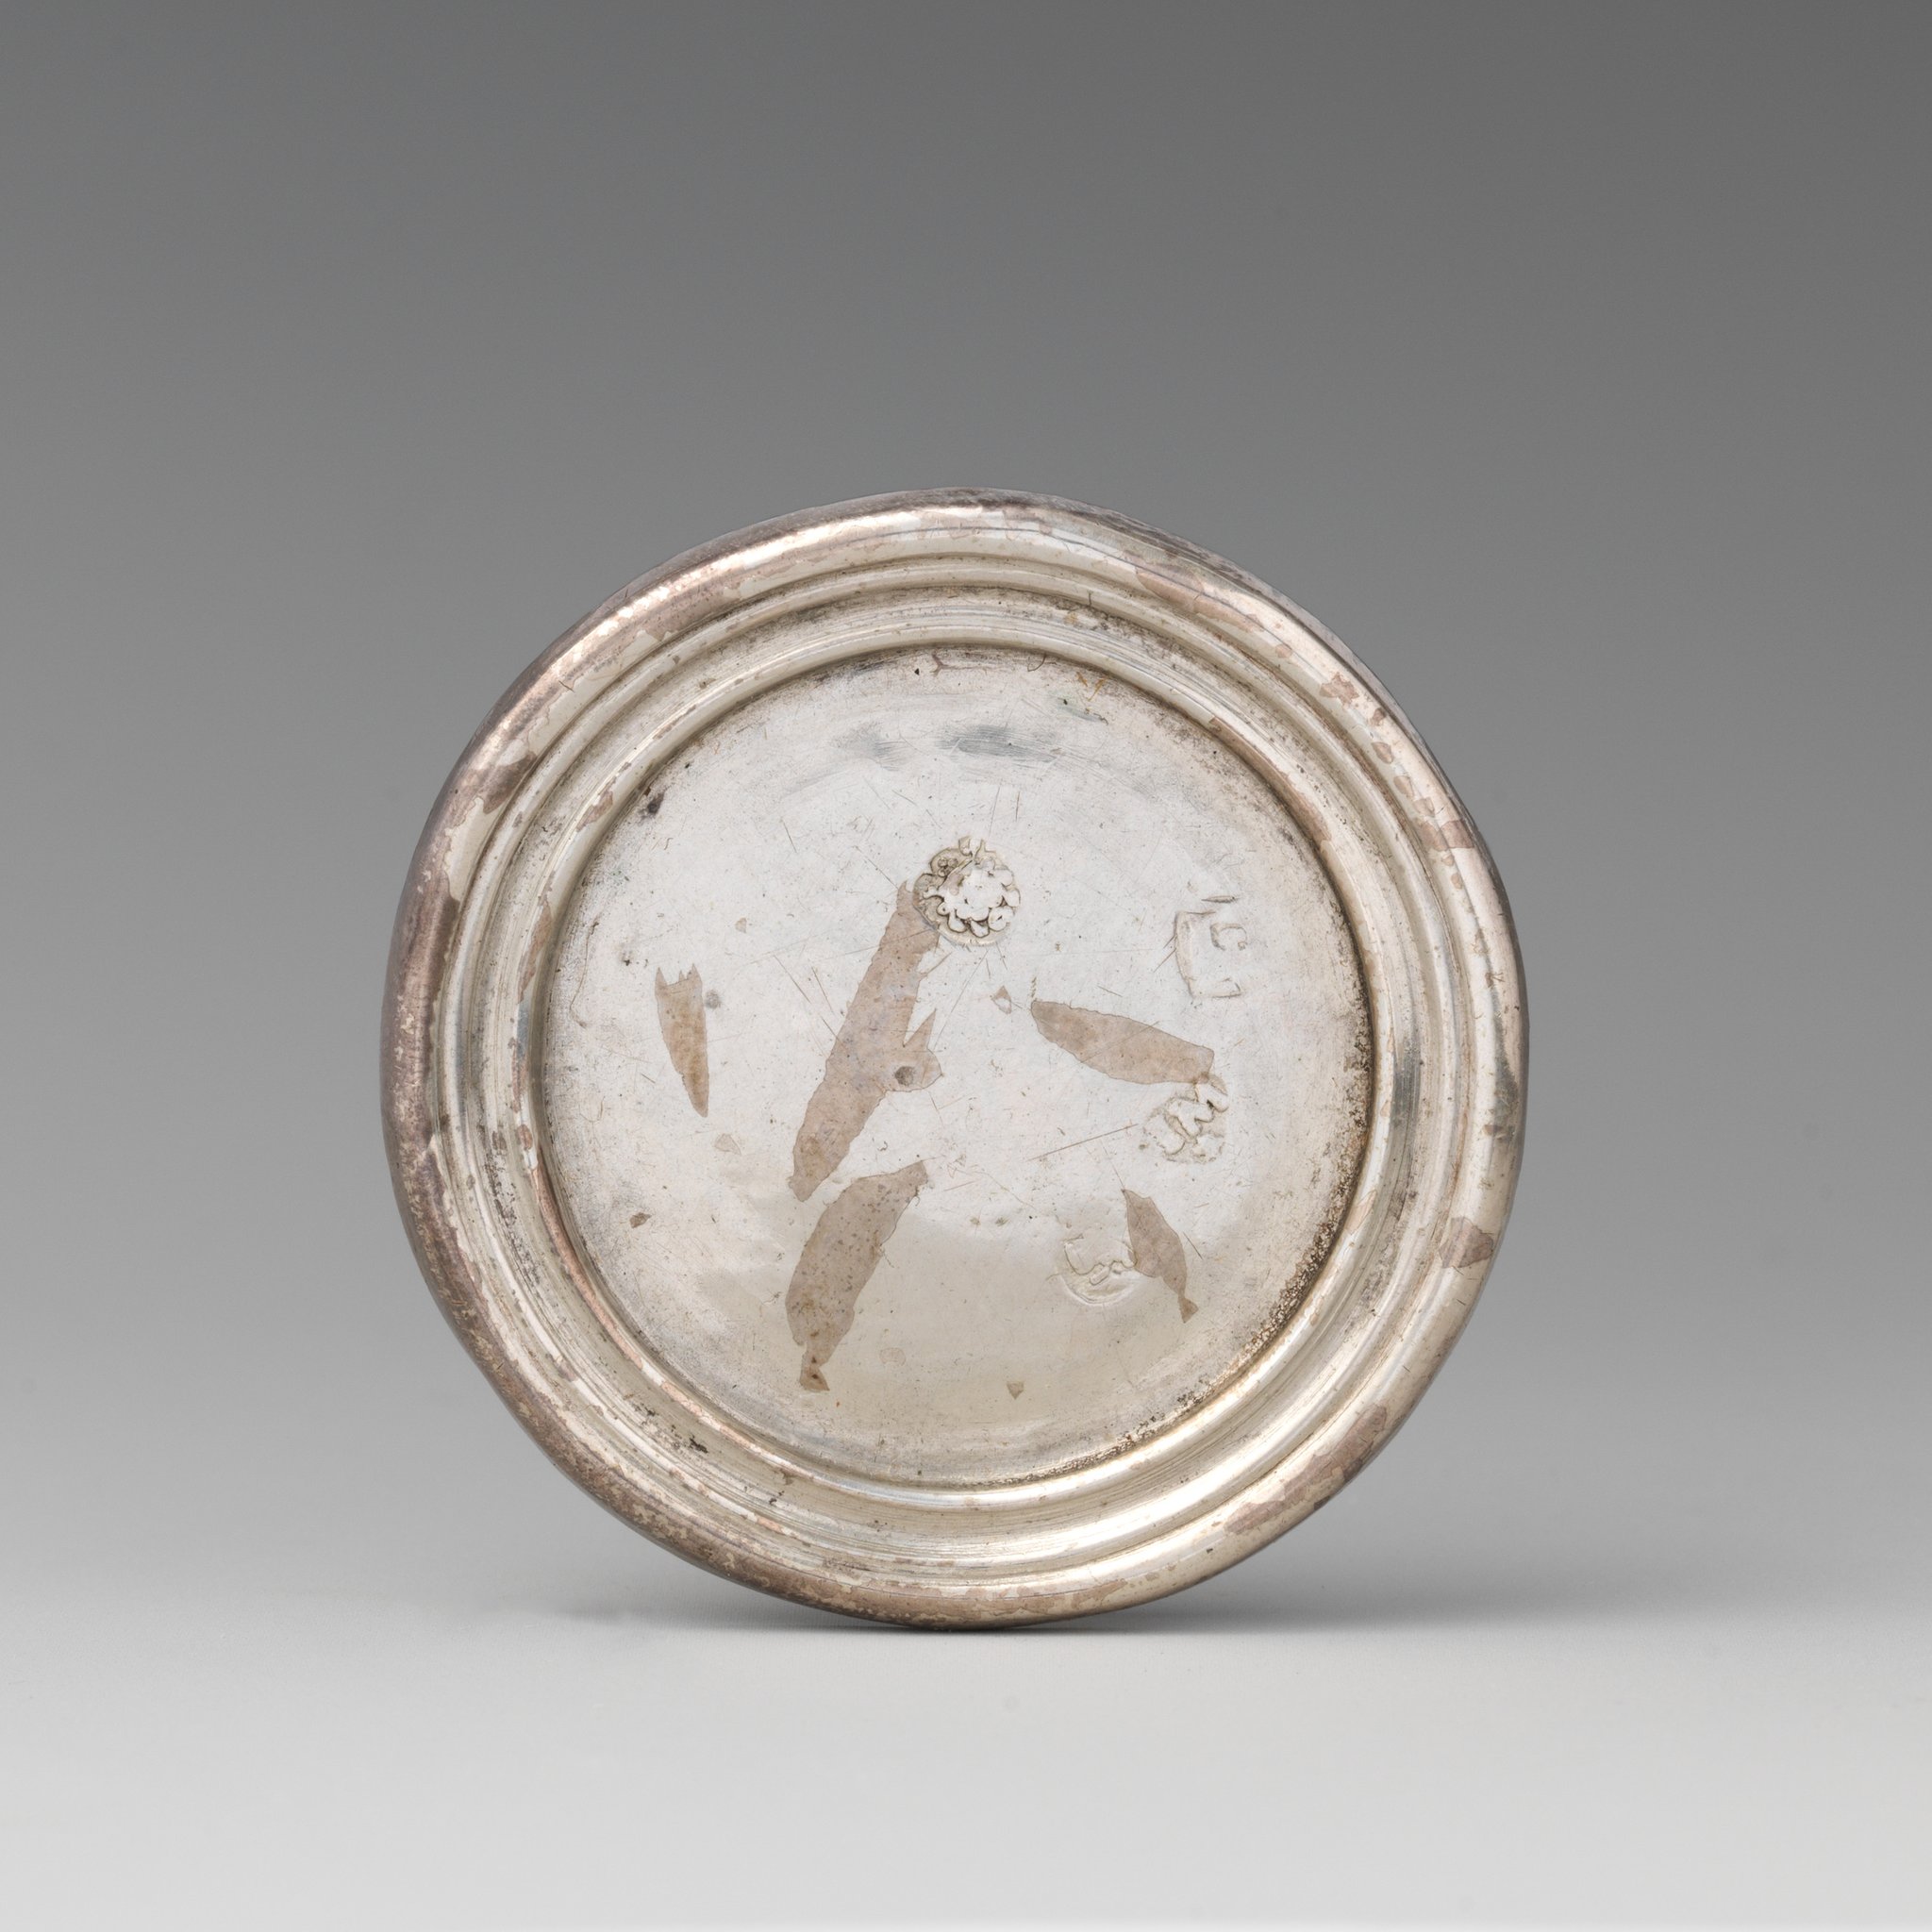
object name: tray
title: Miniature tray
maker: i. m.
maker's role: maker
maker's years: 1720-1769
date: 1720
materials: silver